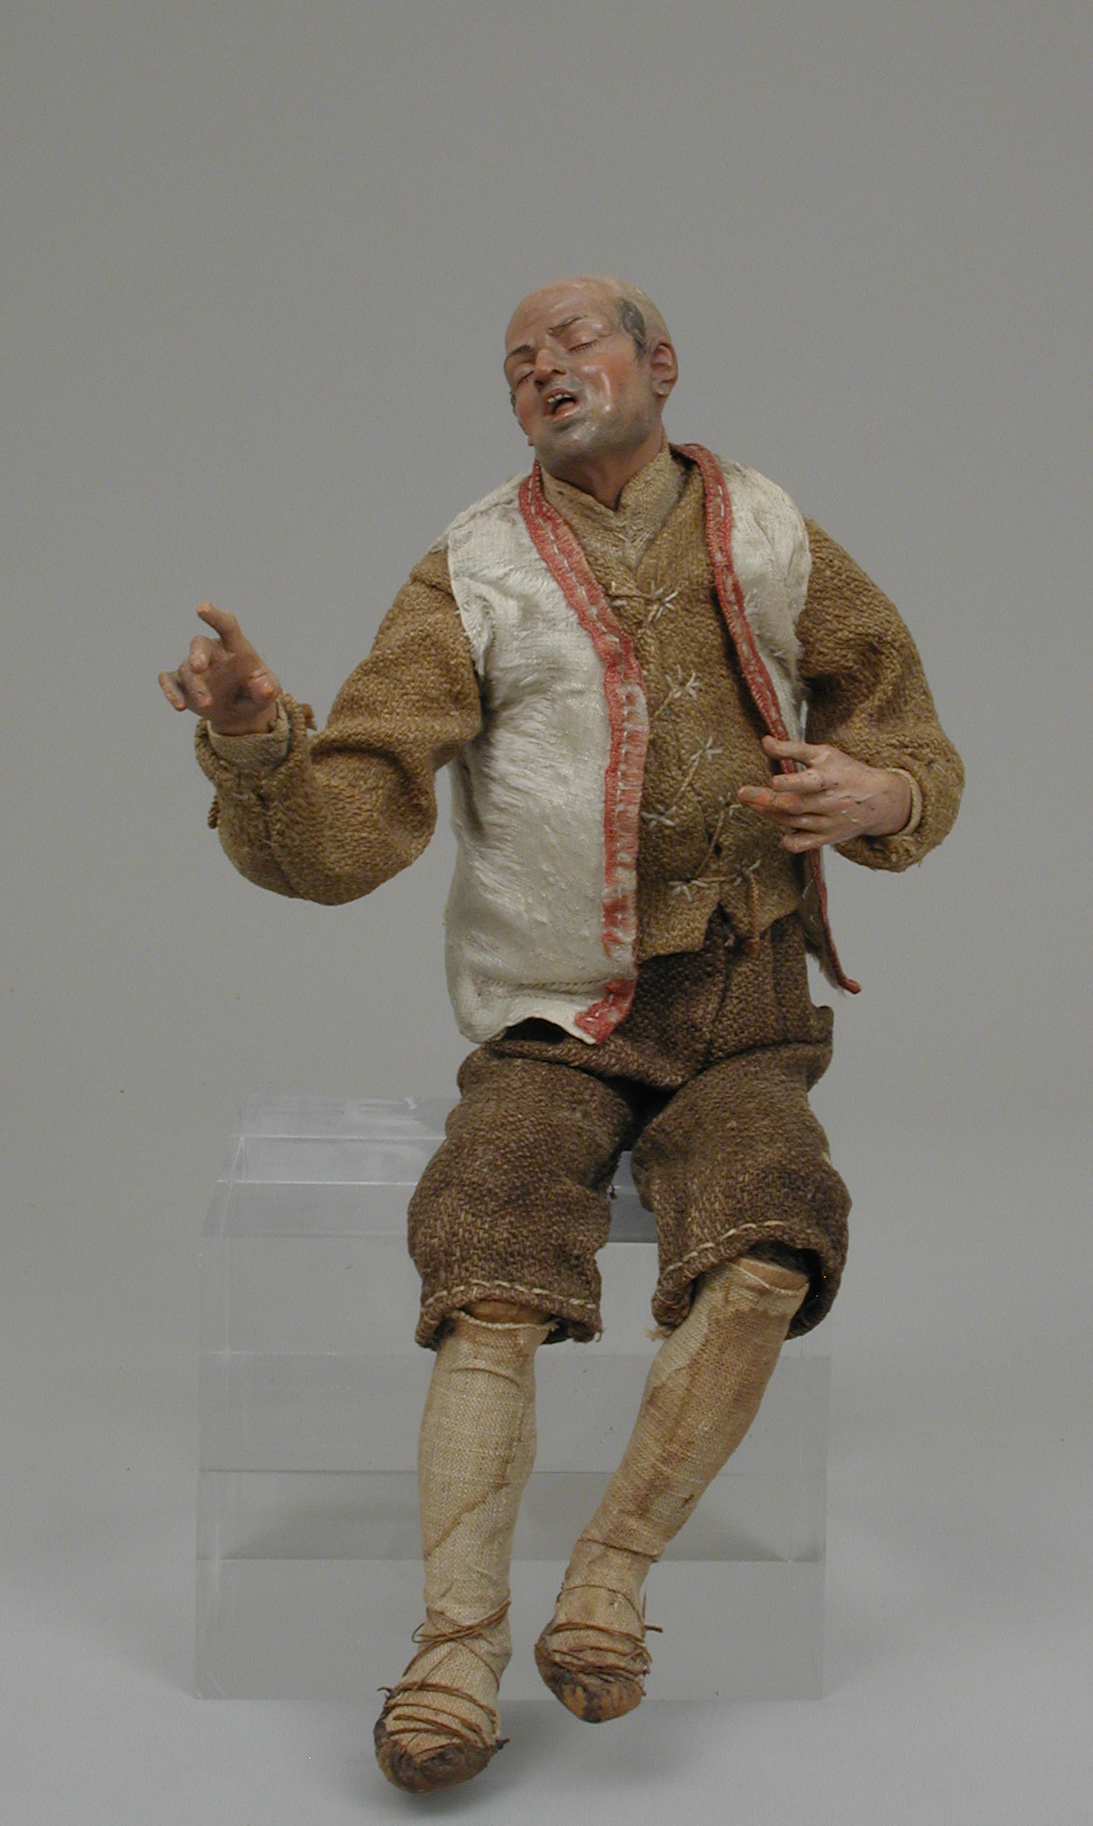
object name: crèche figure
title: Shepherd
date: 1751-1800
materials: cotton, leather, terracotta, fiber, metal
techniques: polychrome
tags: men,shepherds